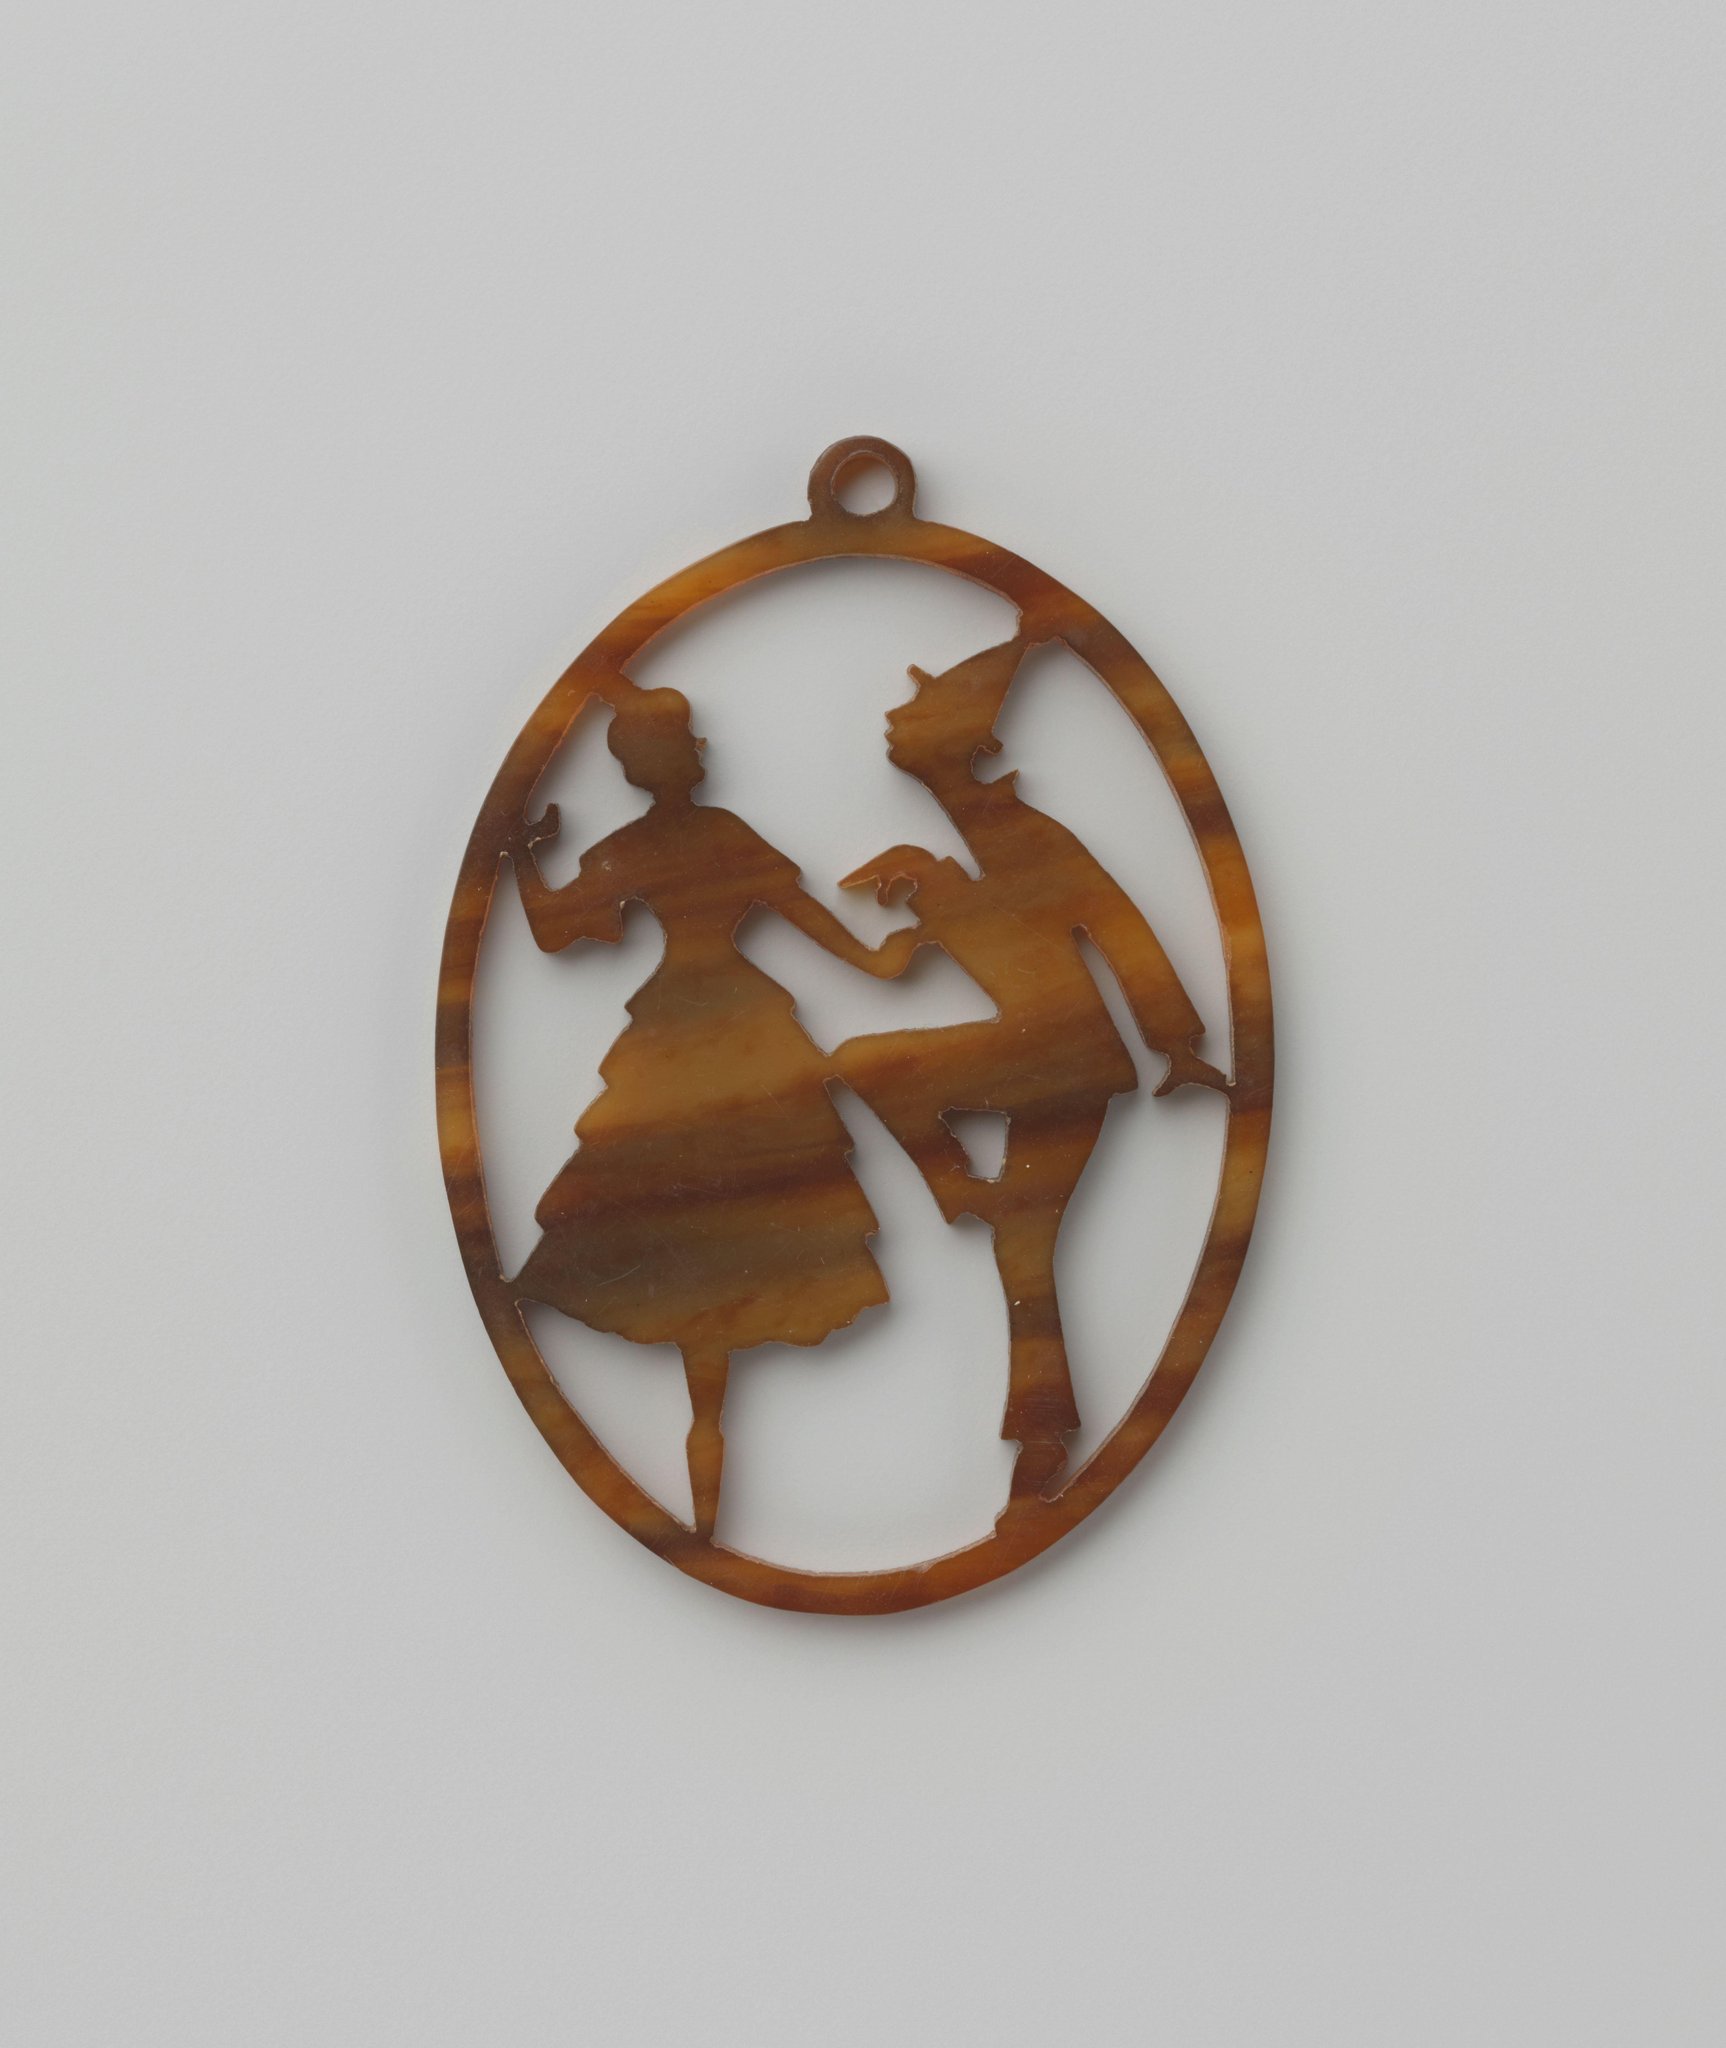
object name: pendant jewelry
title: Hanger van imitatieschildpad met dansend paar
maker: willem van laar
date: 1900-1970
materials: tortoise shell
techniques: cutting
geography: netherlands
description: Hanger met rond oog van imitatieschildpad met dansend paar daarin uitgesneden in ajour.